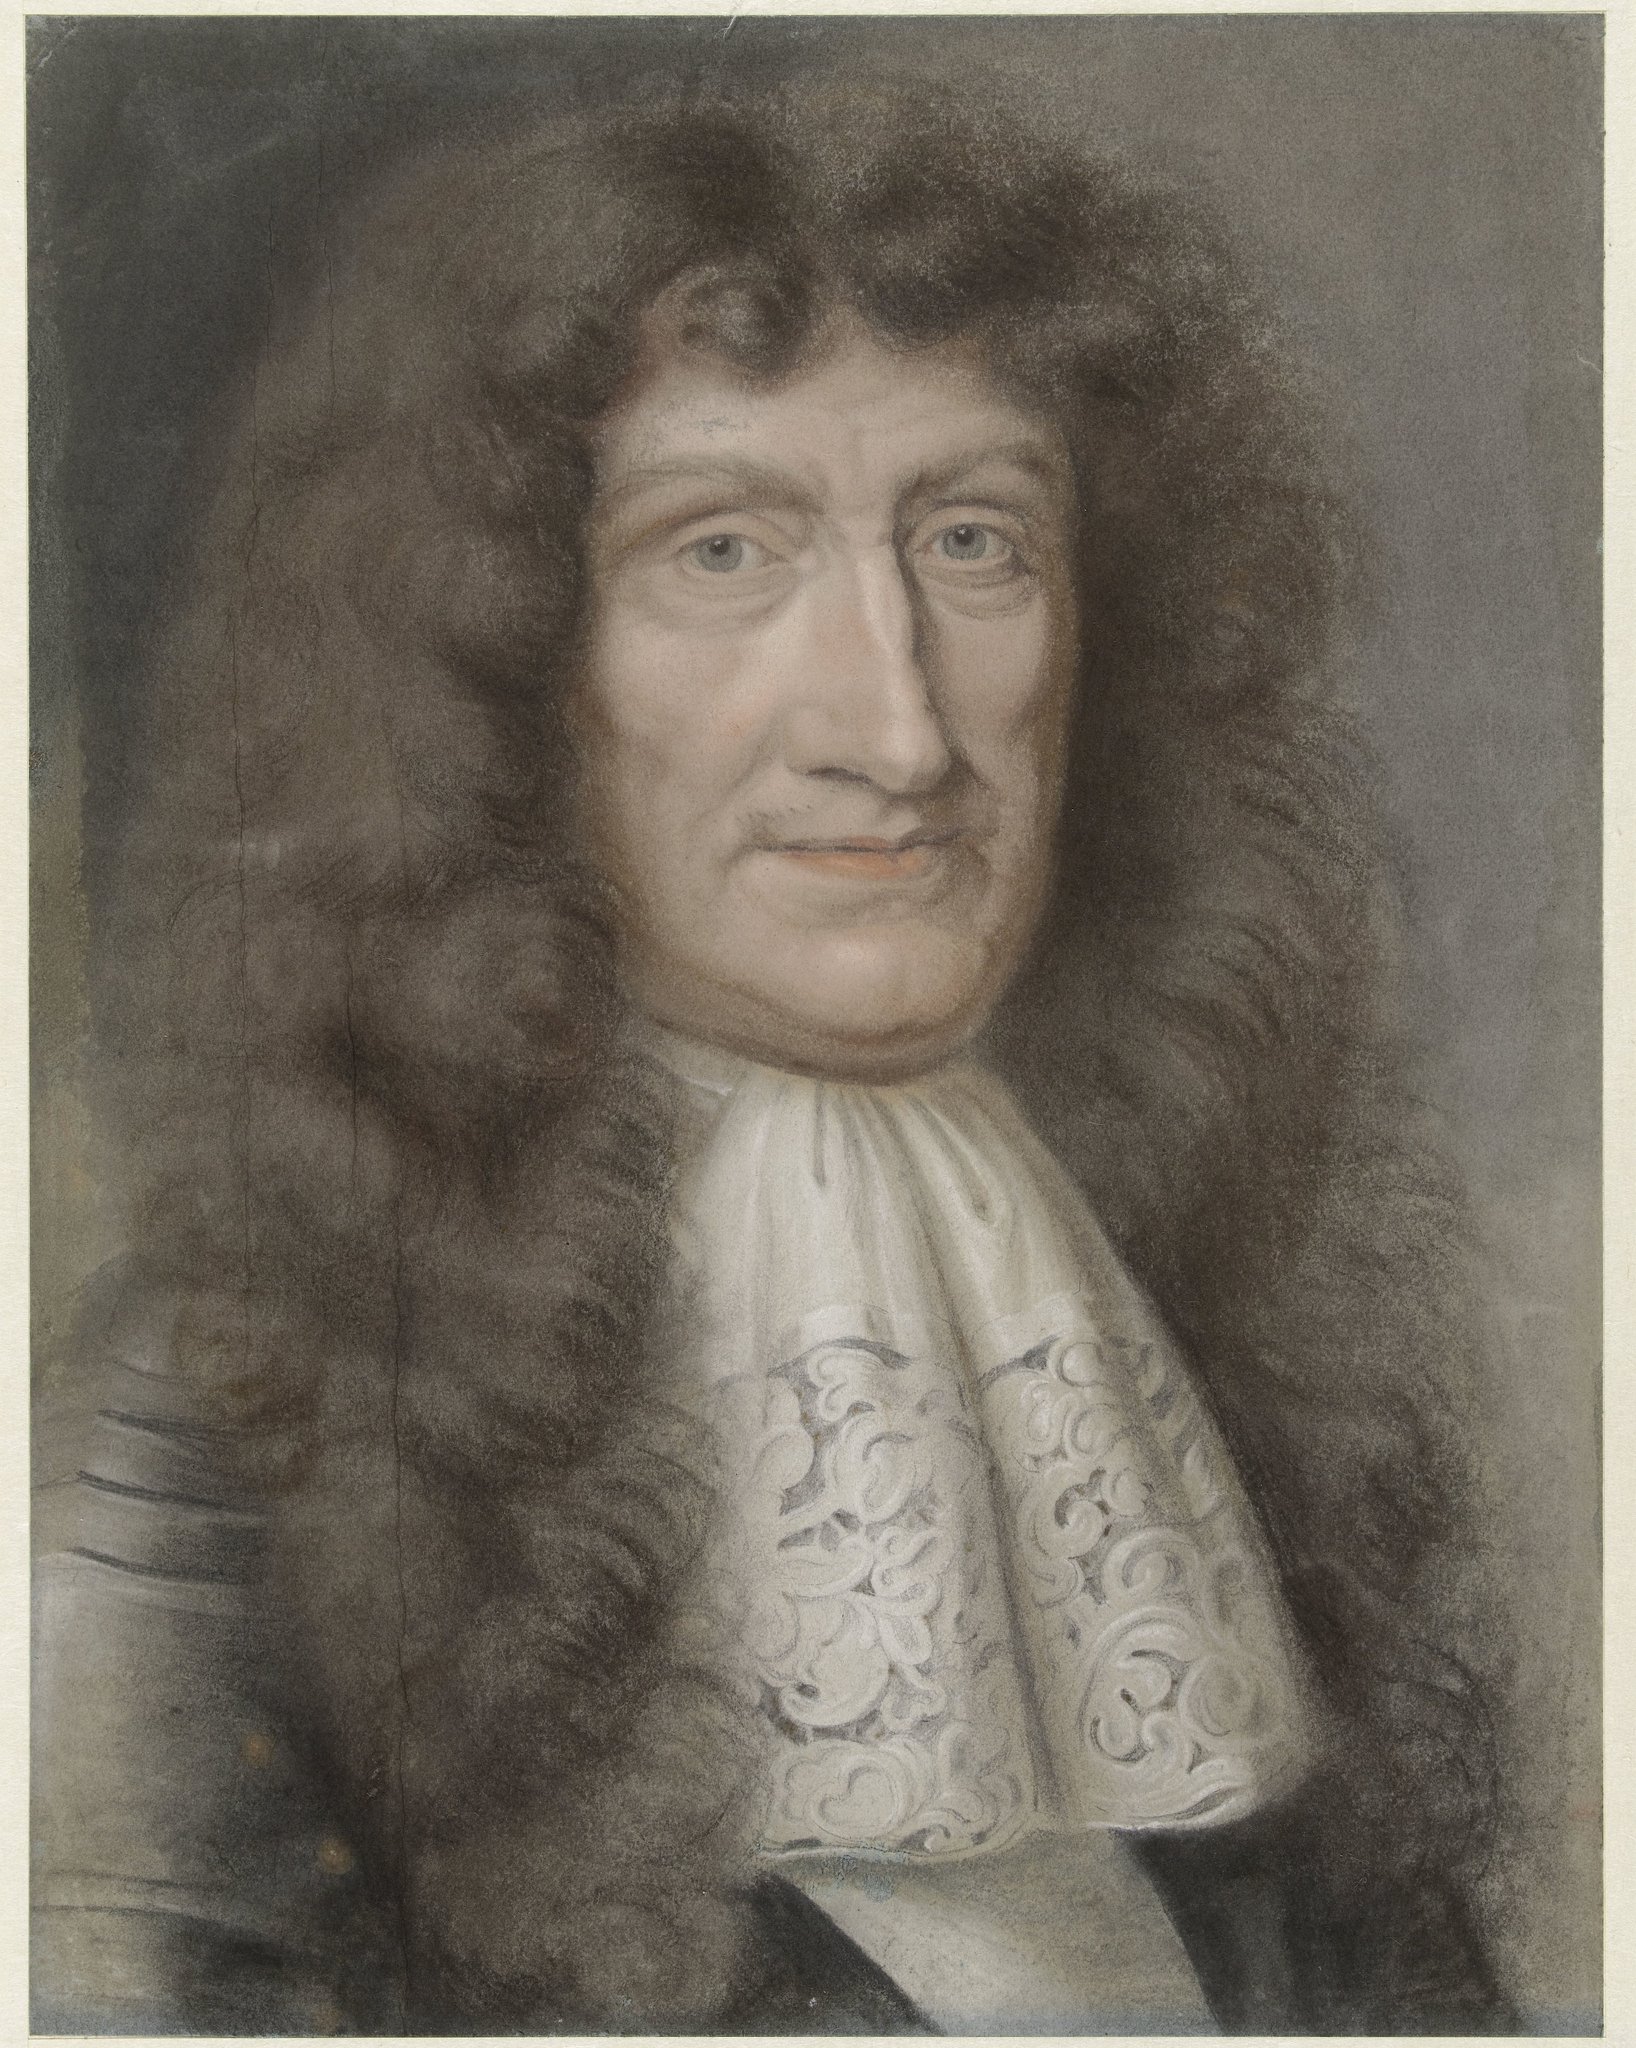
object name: drawing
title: Portret van Louis Godefroi d'Estrades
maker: wallerant vaillant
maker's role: draughtsman, painter, print maker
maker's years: 1623-1677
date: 1647-1677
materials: paper, pastel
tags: paris, historical persons